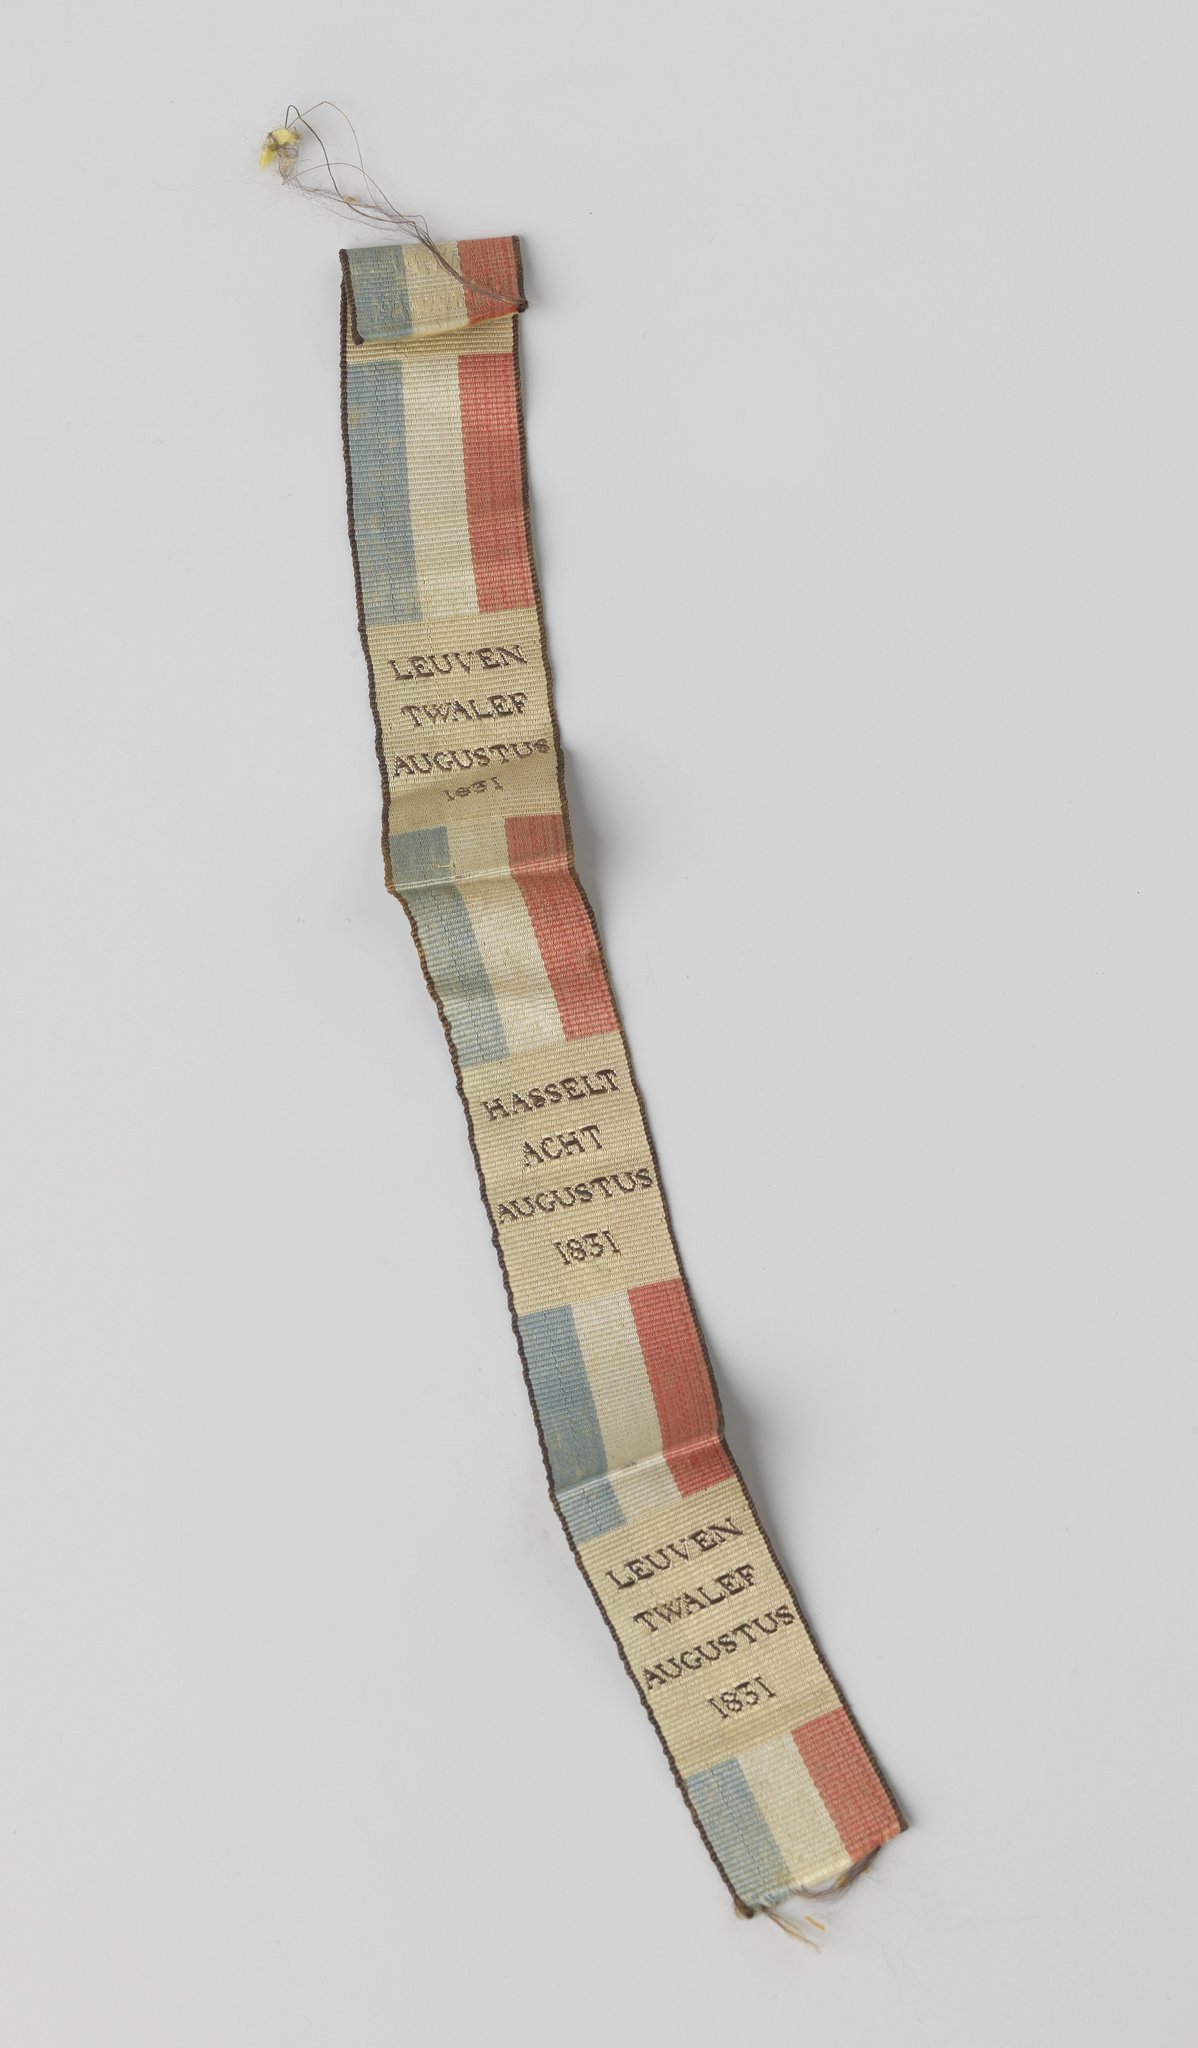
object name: ribbon material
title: Lint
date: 1831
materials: silk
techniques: weave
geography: netherlands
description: Lint met zwarte zijden, rood-wit-blauwe banen onderbroken door verschoten oranje rechthoekjes met om de de beurt het opschrift "HASSELT...." en "LEUVEN".